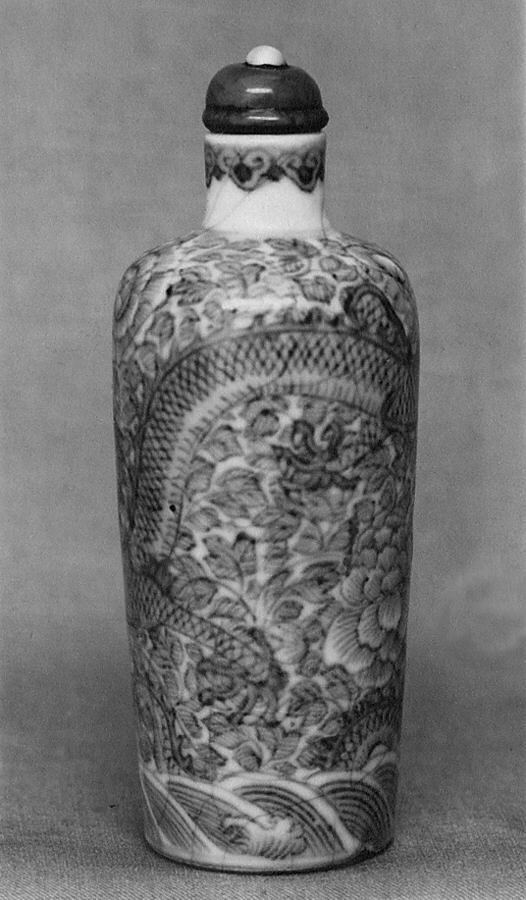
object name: snuff bottle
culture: chinese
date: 1801-1900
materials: porcelain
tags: dragons,flowers